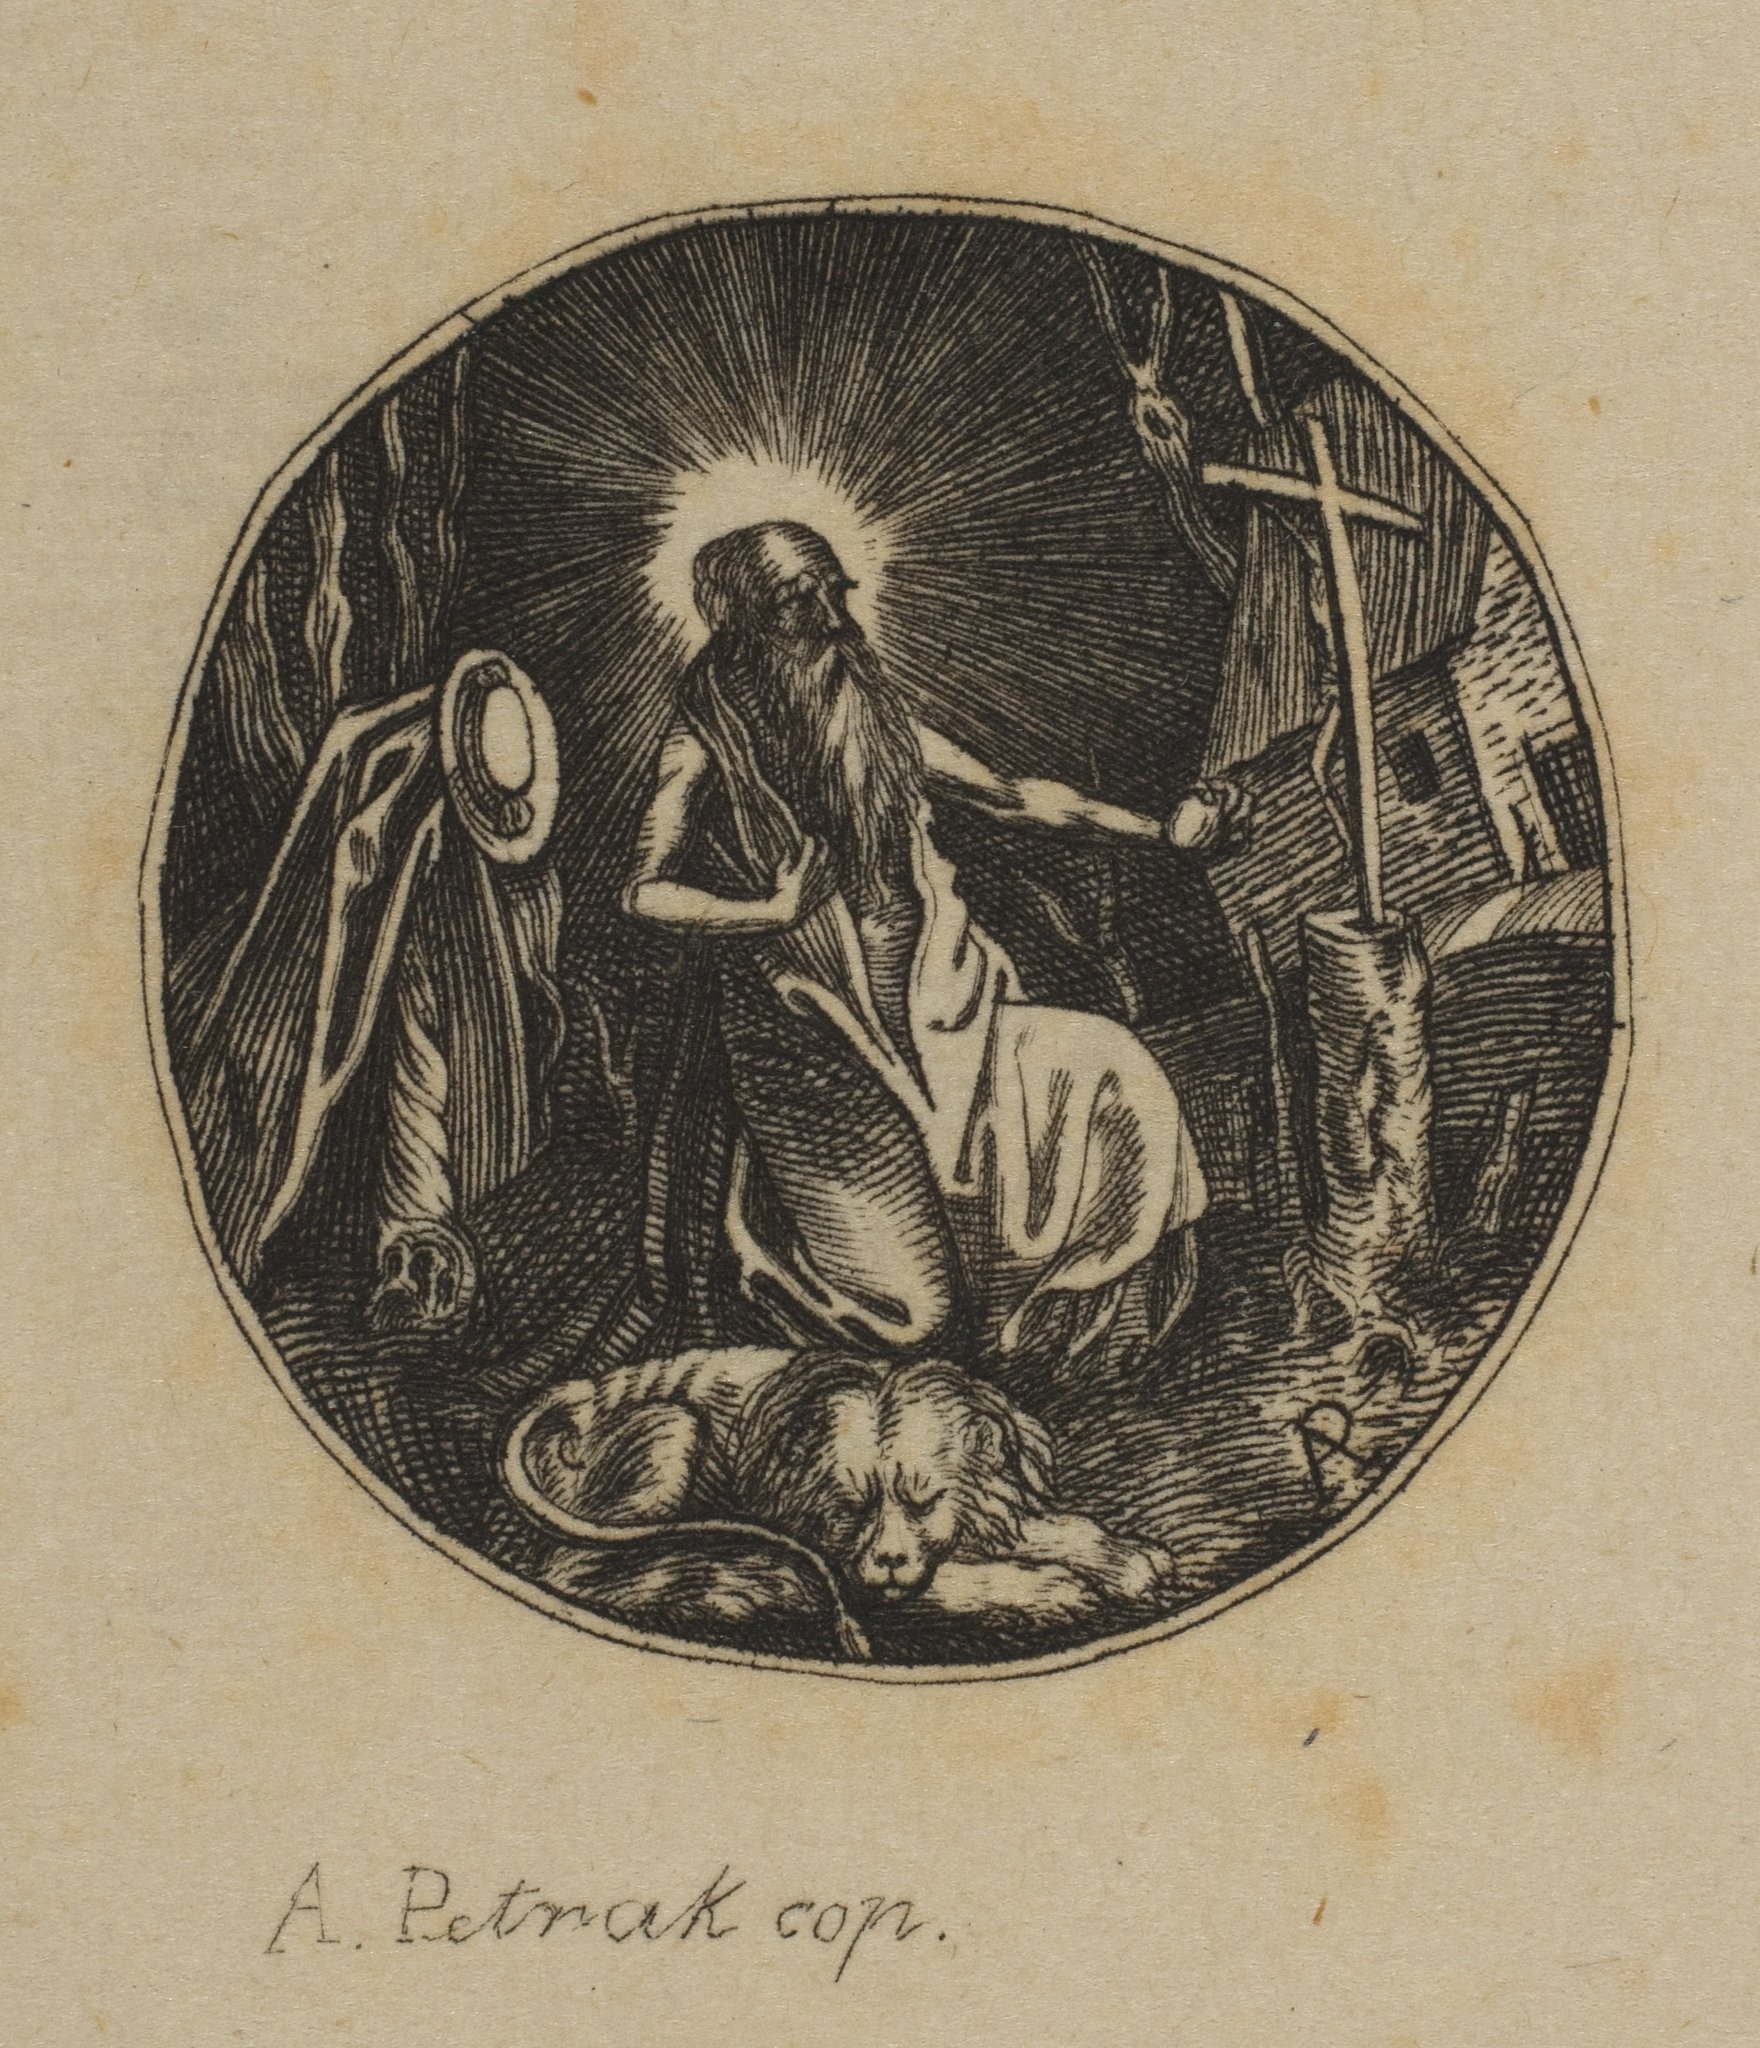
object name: print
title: Saint Jerome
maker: alois petrak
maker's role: artist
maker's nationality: czech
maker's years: 1811-1888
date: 1801-1900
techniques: engraving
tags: lions,saint jerome,cross